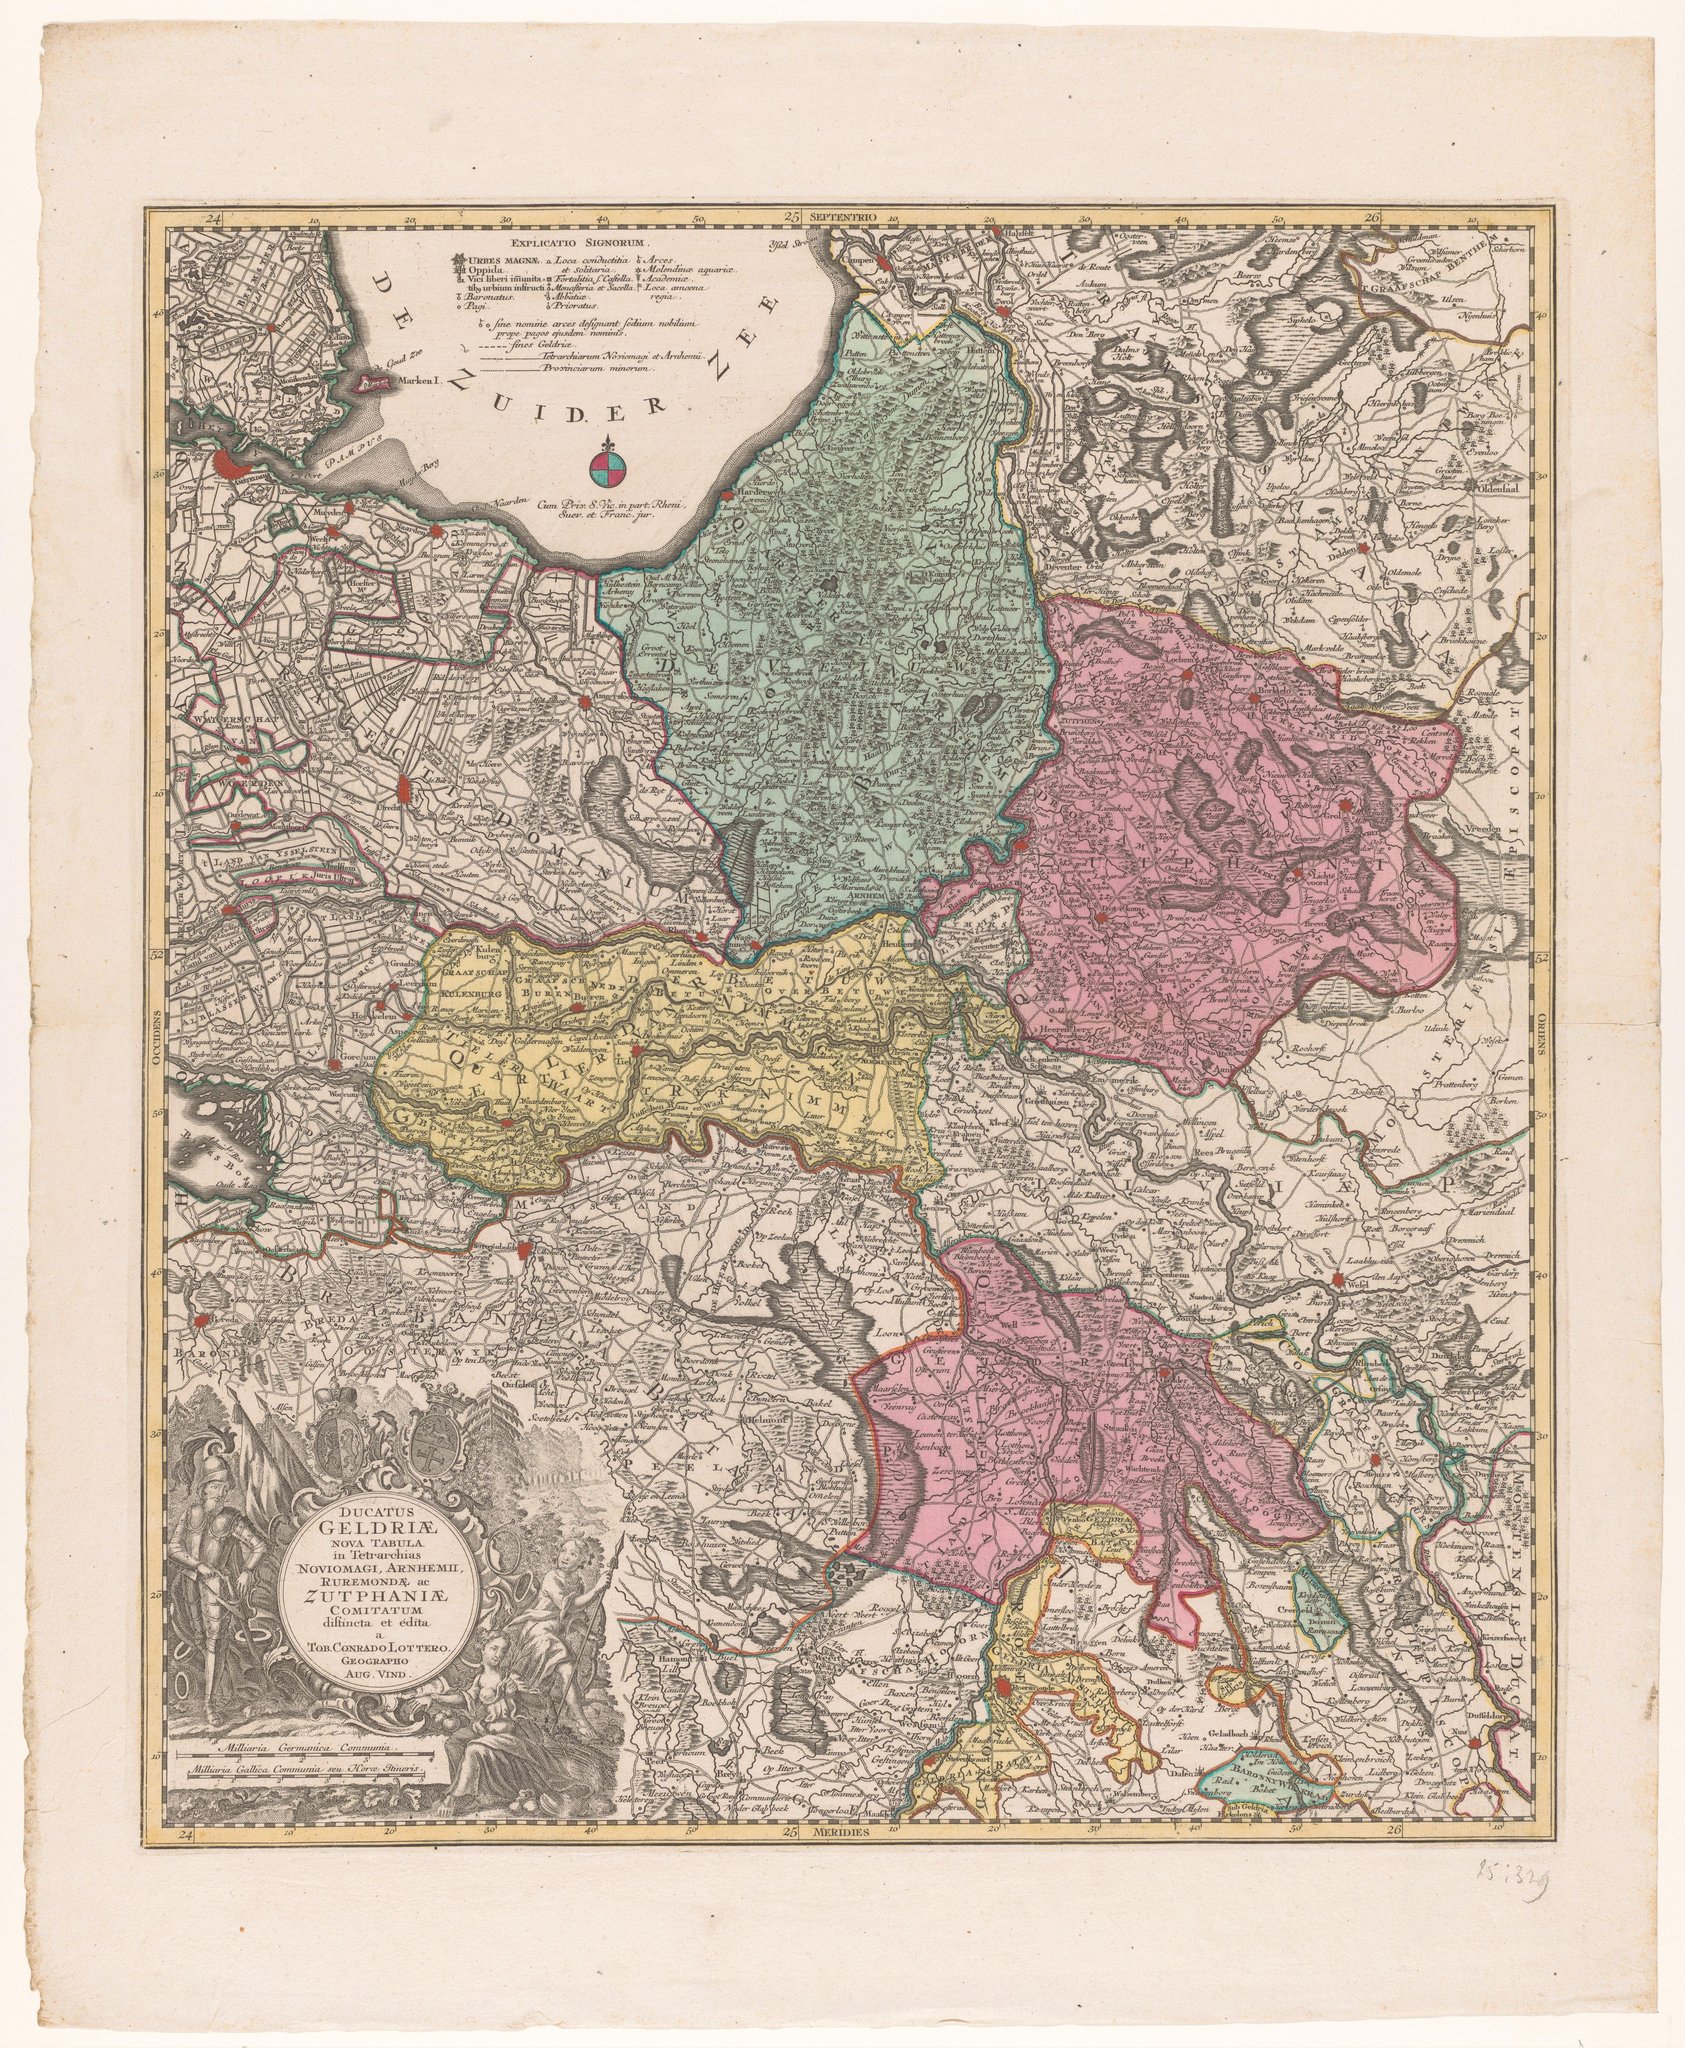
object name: print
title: Kaart van Gelderland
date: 1757-1777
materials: paper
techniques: engraving, etching, hand coloring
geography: augsburg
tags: coat of arms (as symbol of the state, etc.) (+ city; municipal), maps of separate countries or regions, hunting, chase, coat of arms (as symbol of the state, etc.) (+ province; provincial), gelderland, guelders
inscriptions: collector's mark: Lugt 2228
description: Linksonder de titelcartouche en twee schaalstokken: 4 Milliaria Germanica Communia / 5 Milliaria Gallica Communia seu Horae Itineris. Boven de cartouche het wapen van Gelre en van de stad Zutphen. Rond de cartouche figuren. Linksboven een legenda. De kaart is voorzien van een gradenverdeling langs de randen.